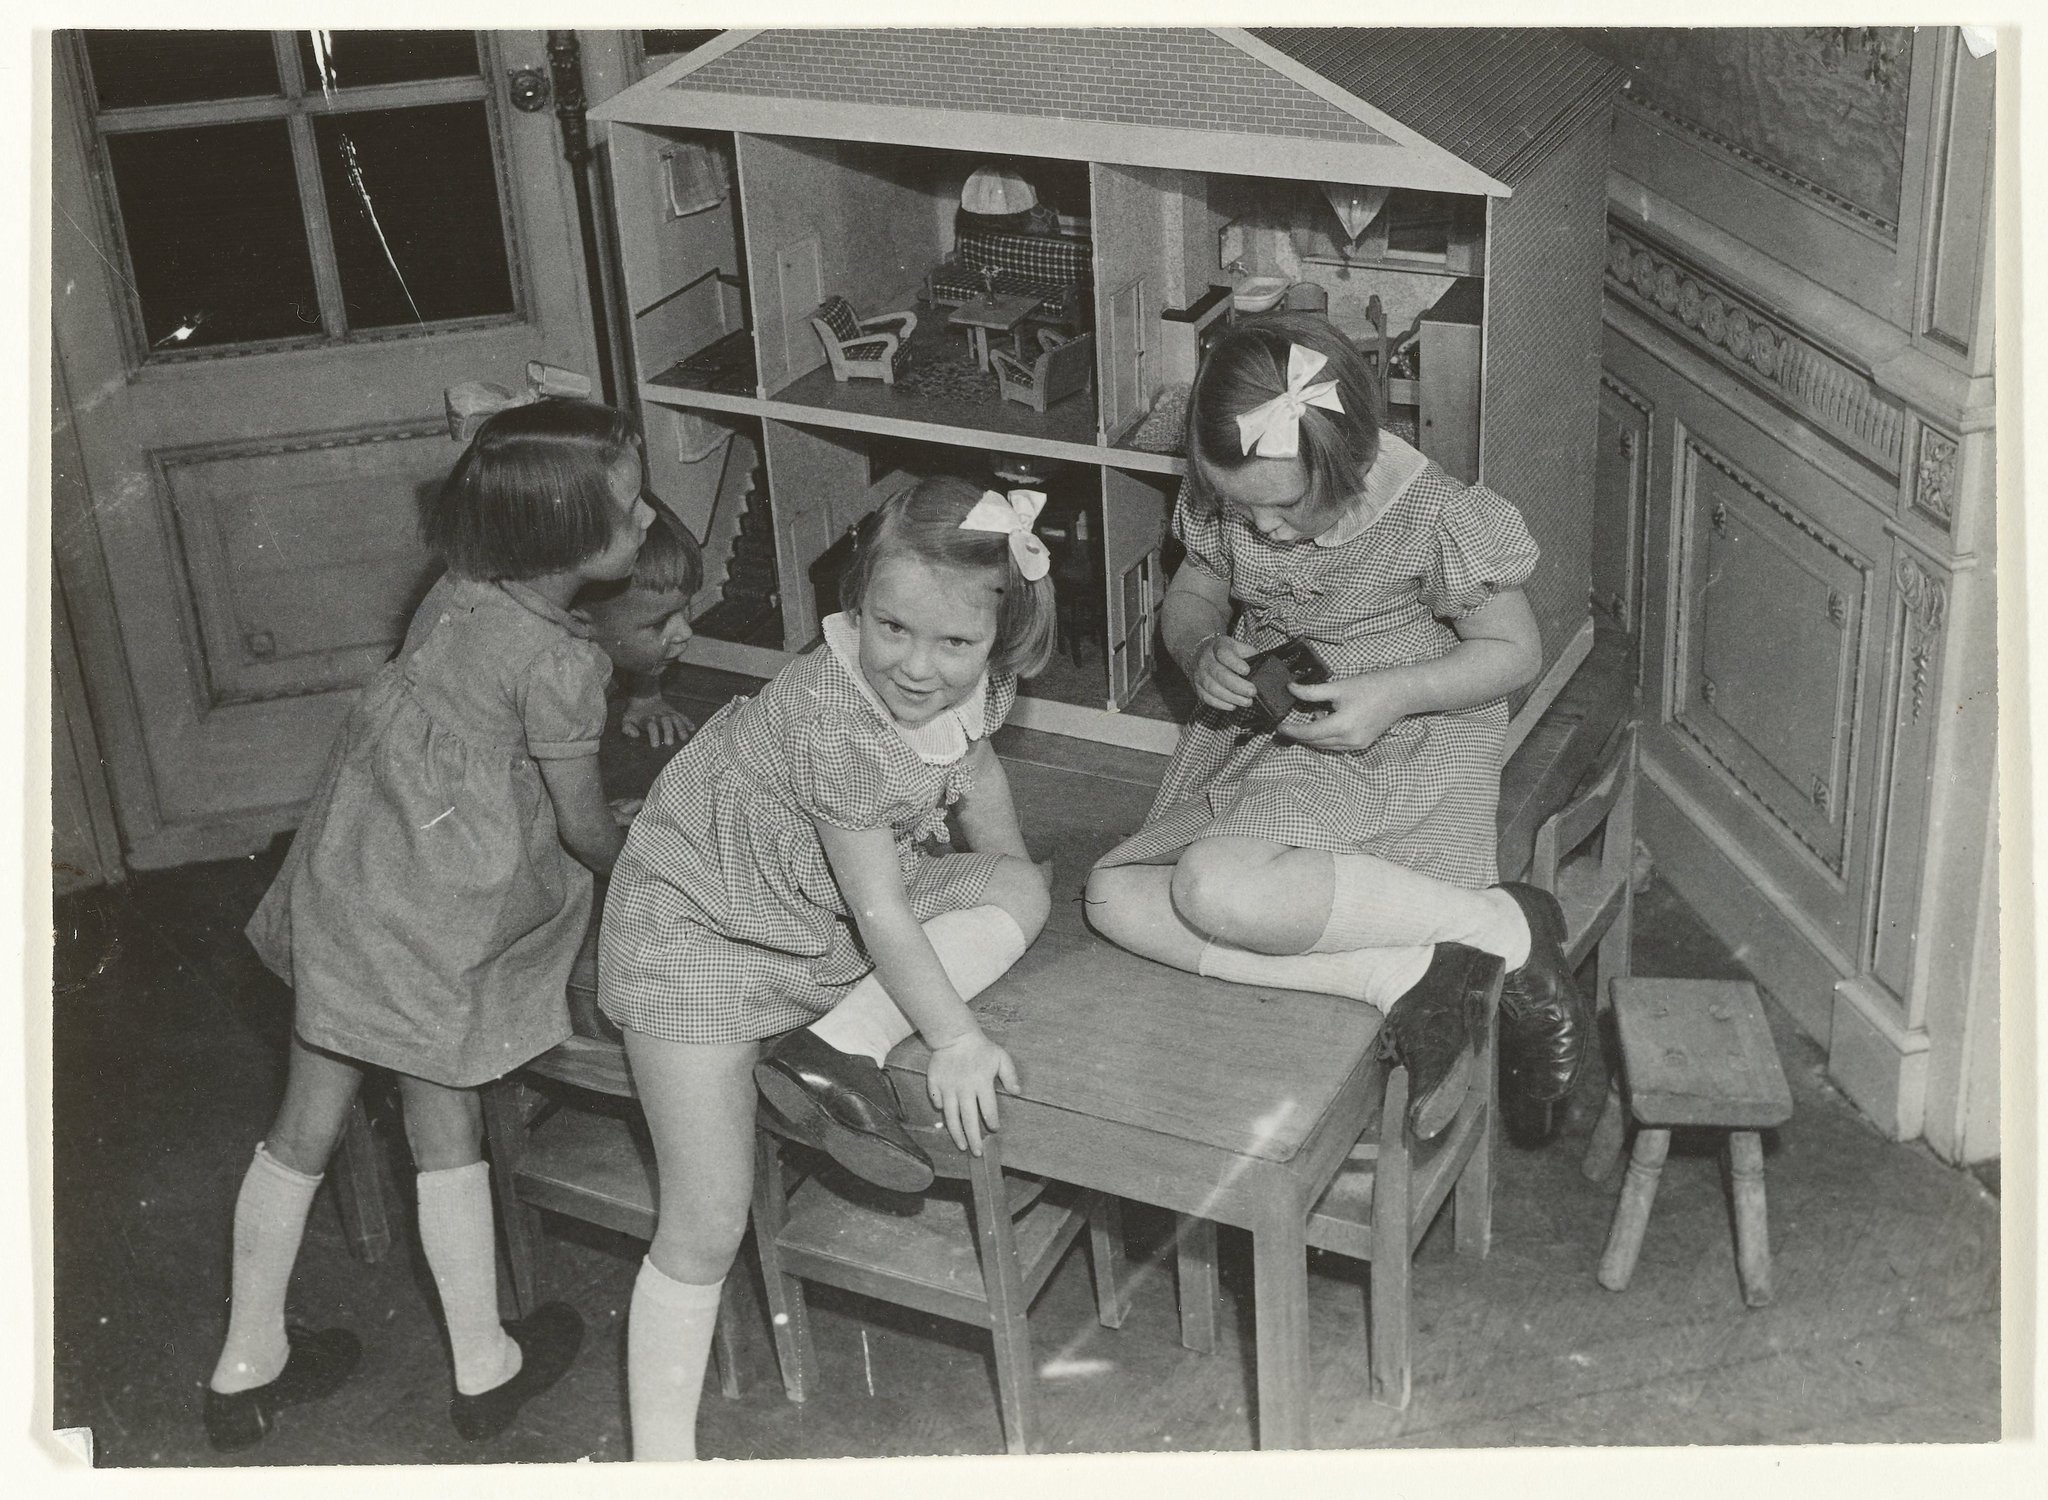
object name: photograph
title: Beatrix en Irene in het Kabouterhuis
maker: koos raucamp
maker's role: fotograaf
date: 1901-1946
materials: photographic support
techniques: photography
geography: amsterdam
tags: beatrix (koningin der nederlanden), the hague, juliana of the netherlands, amsterdam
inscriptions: stamp: ‘COPYRIGHT / 'ANEFO' / ALGEMEEN NEDERLANDSCH FOTOBUREAU’, inscription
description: Beatrix en Irene hebben een poppenhuis geschonken aan het Kabouterhuis, een tehuis voor ziekelijke kinderen, ter gelegenheid van de opening.